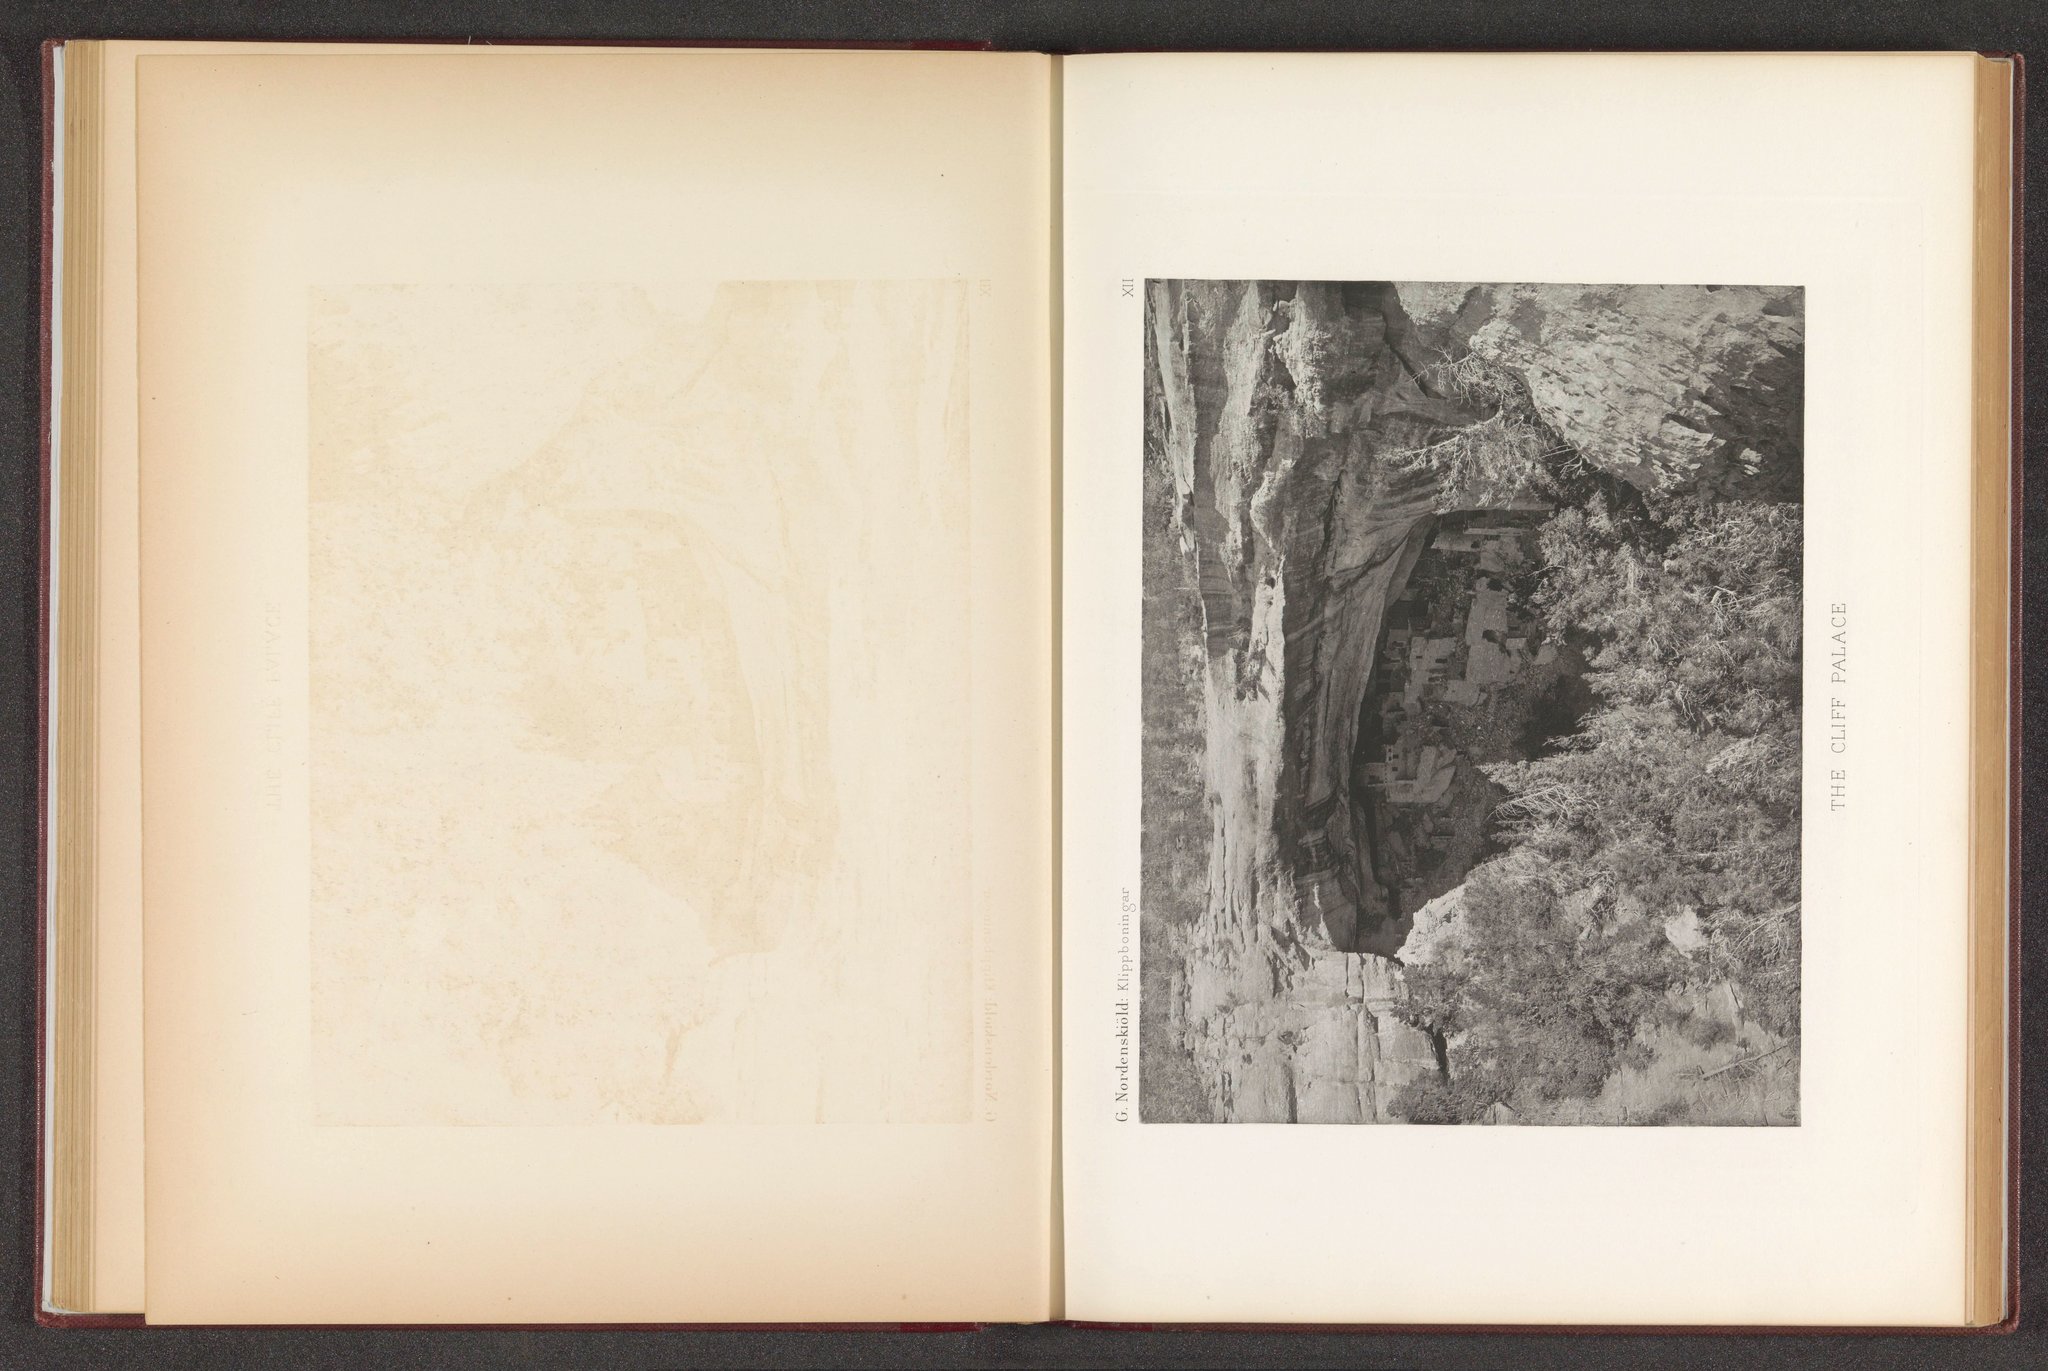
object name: page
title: Gezicht op het Cliff Palace in Mesa Verde National Park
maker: gustaf nordenskiöld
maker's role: fotograaf, schrijver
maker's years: 1868-1895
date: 1891-1893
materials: paper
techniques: photoaquatint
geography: mesa verde national park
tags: cave-dwelling, ruin of a dwelling, house, castle, etc.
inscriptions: inscription: ‘G. Nordenskiöld: Klippboningar.’, number: ‘XII’